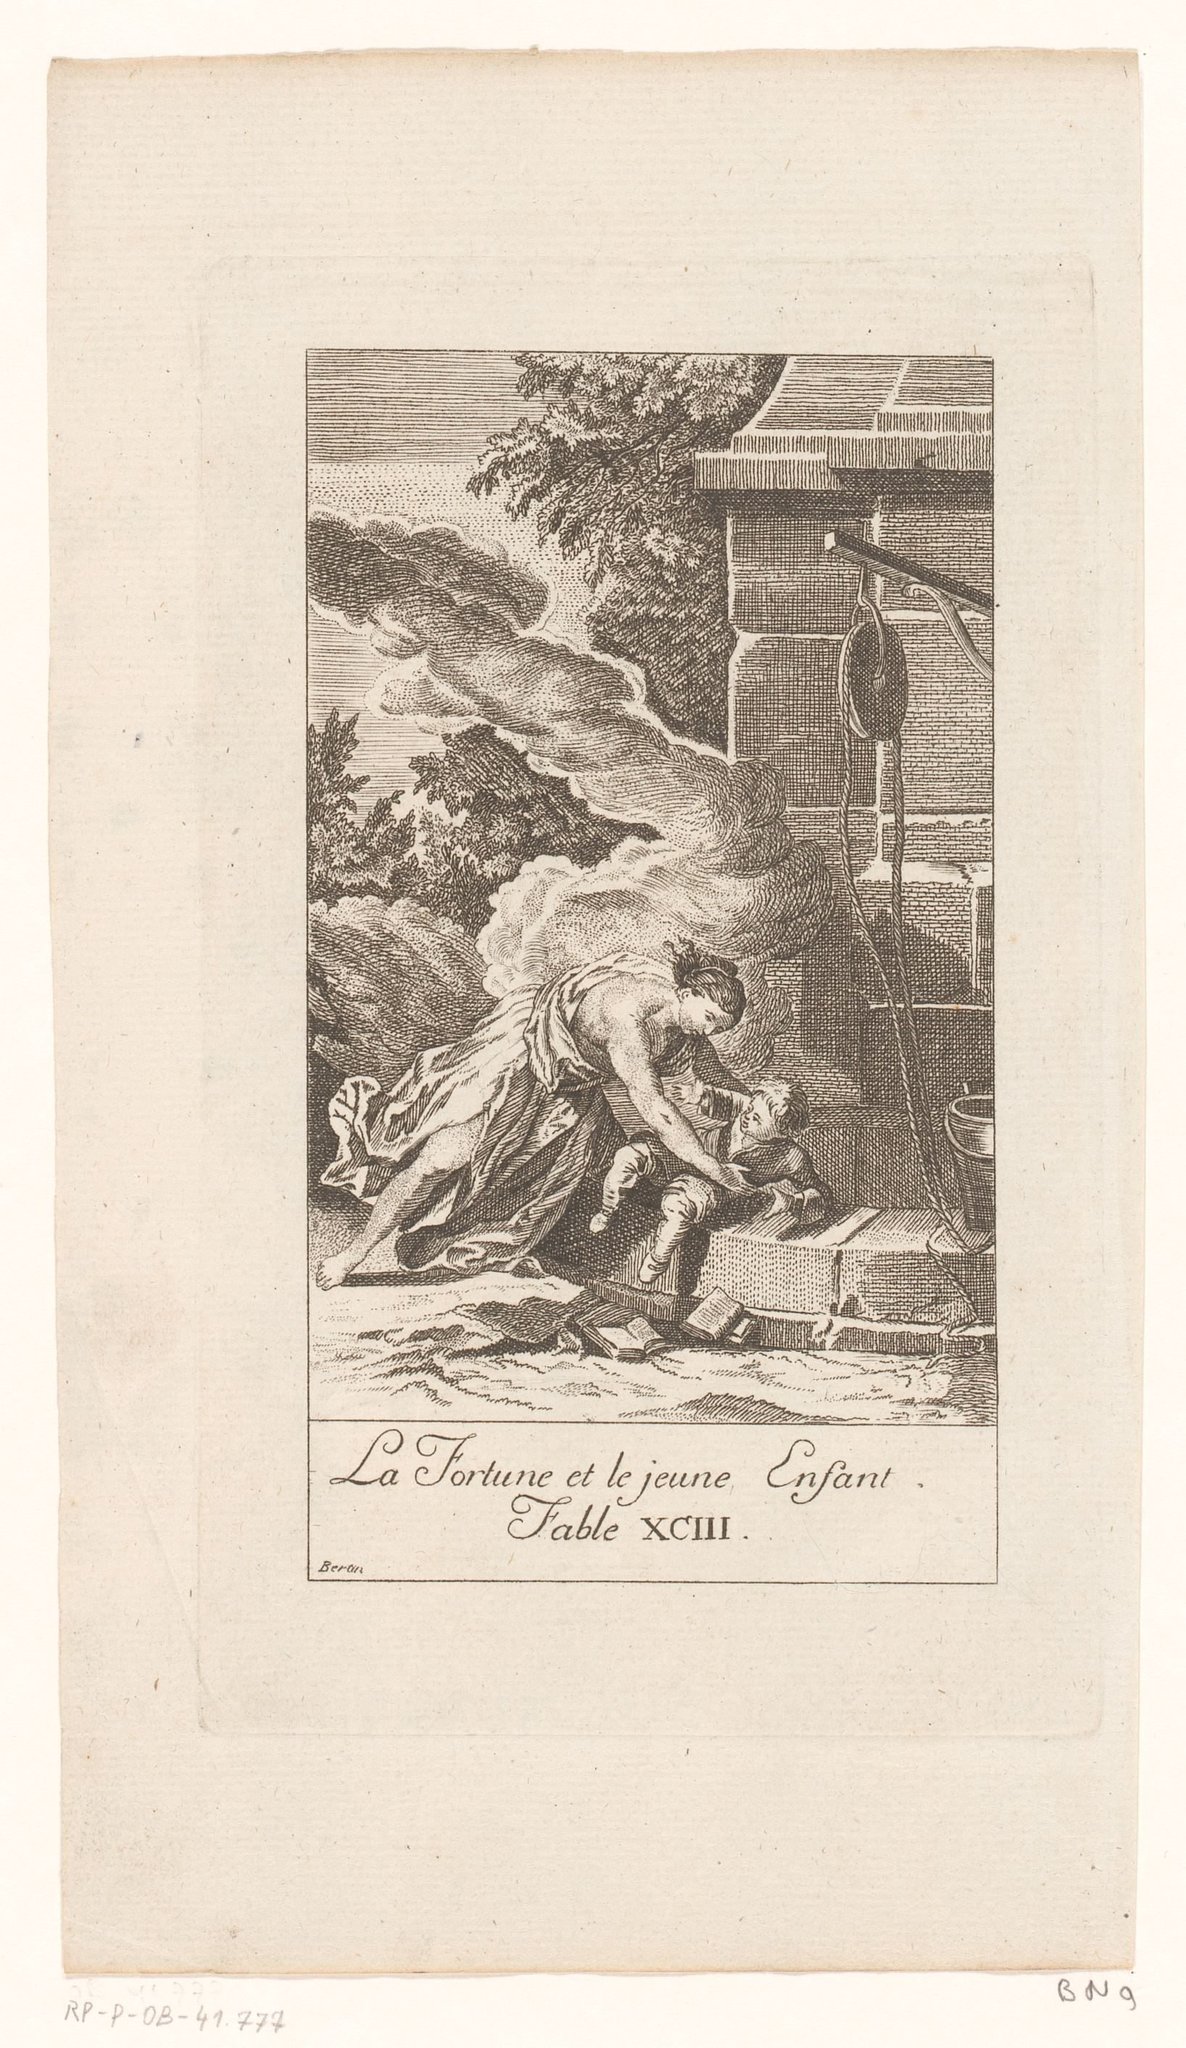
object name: book illustration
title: La Fortune et le jeune Enfant.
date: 1776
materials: paper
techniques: etching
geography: france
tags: child, fortuna as roman personification, fables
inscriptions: collector's mark: Lugt 2228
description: Prent uit: Fontaine, Jean de la. Fables Choisies: Bouillon, Aux depens de la Société typographique. S.l.: s.d, 1776, dl. 2.